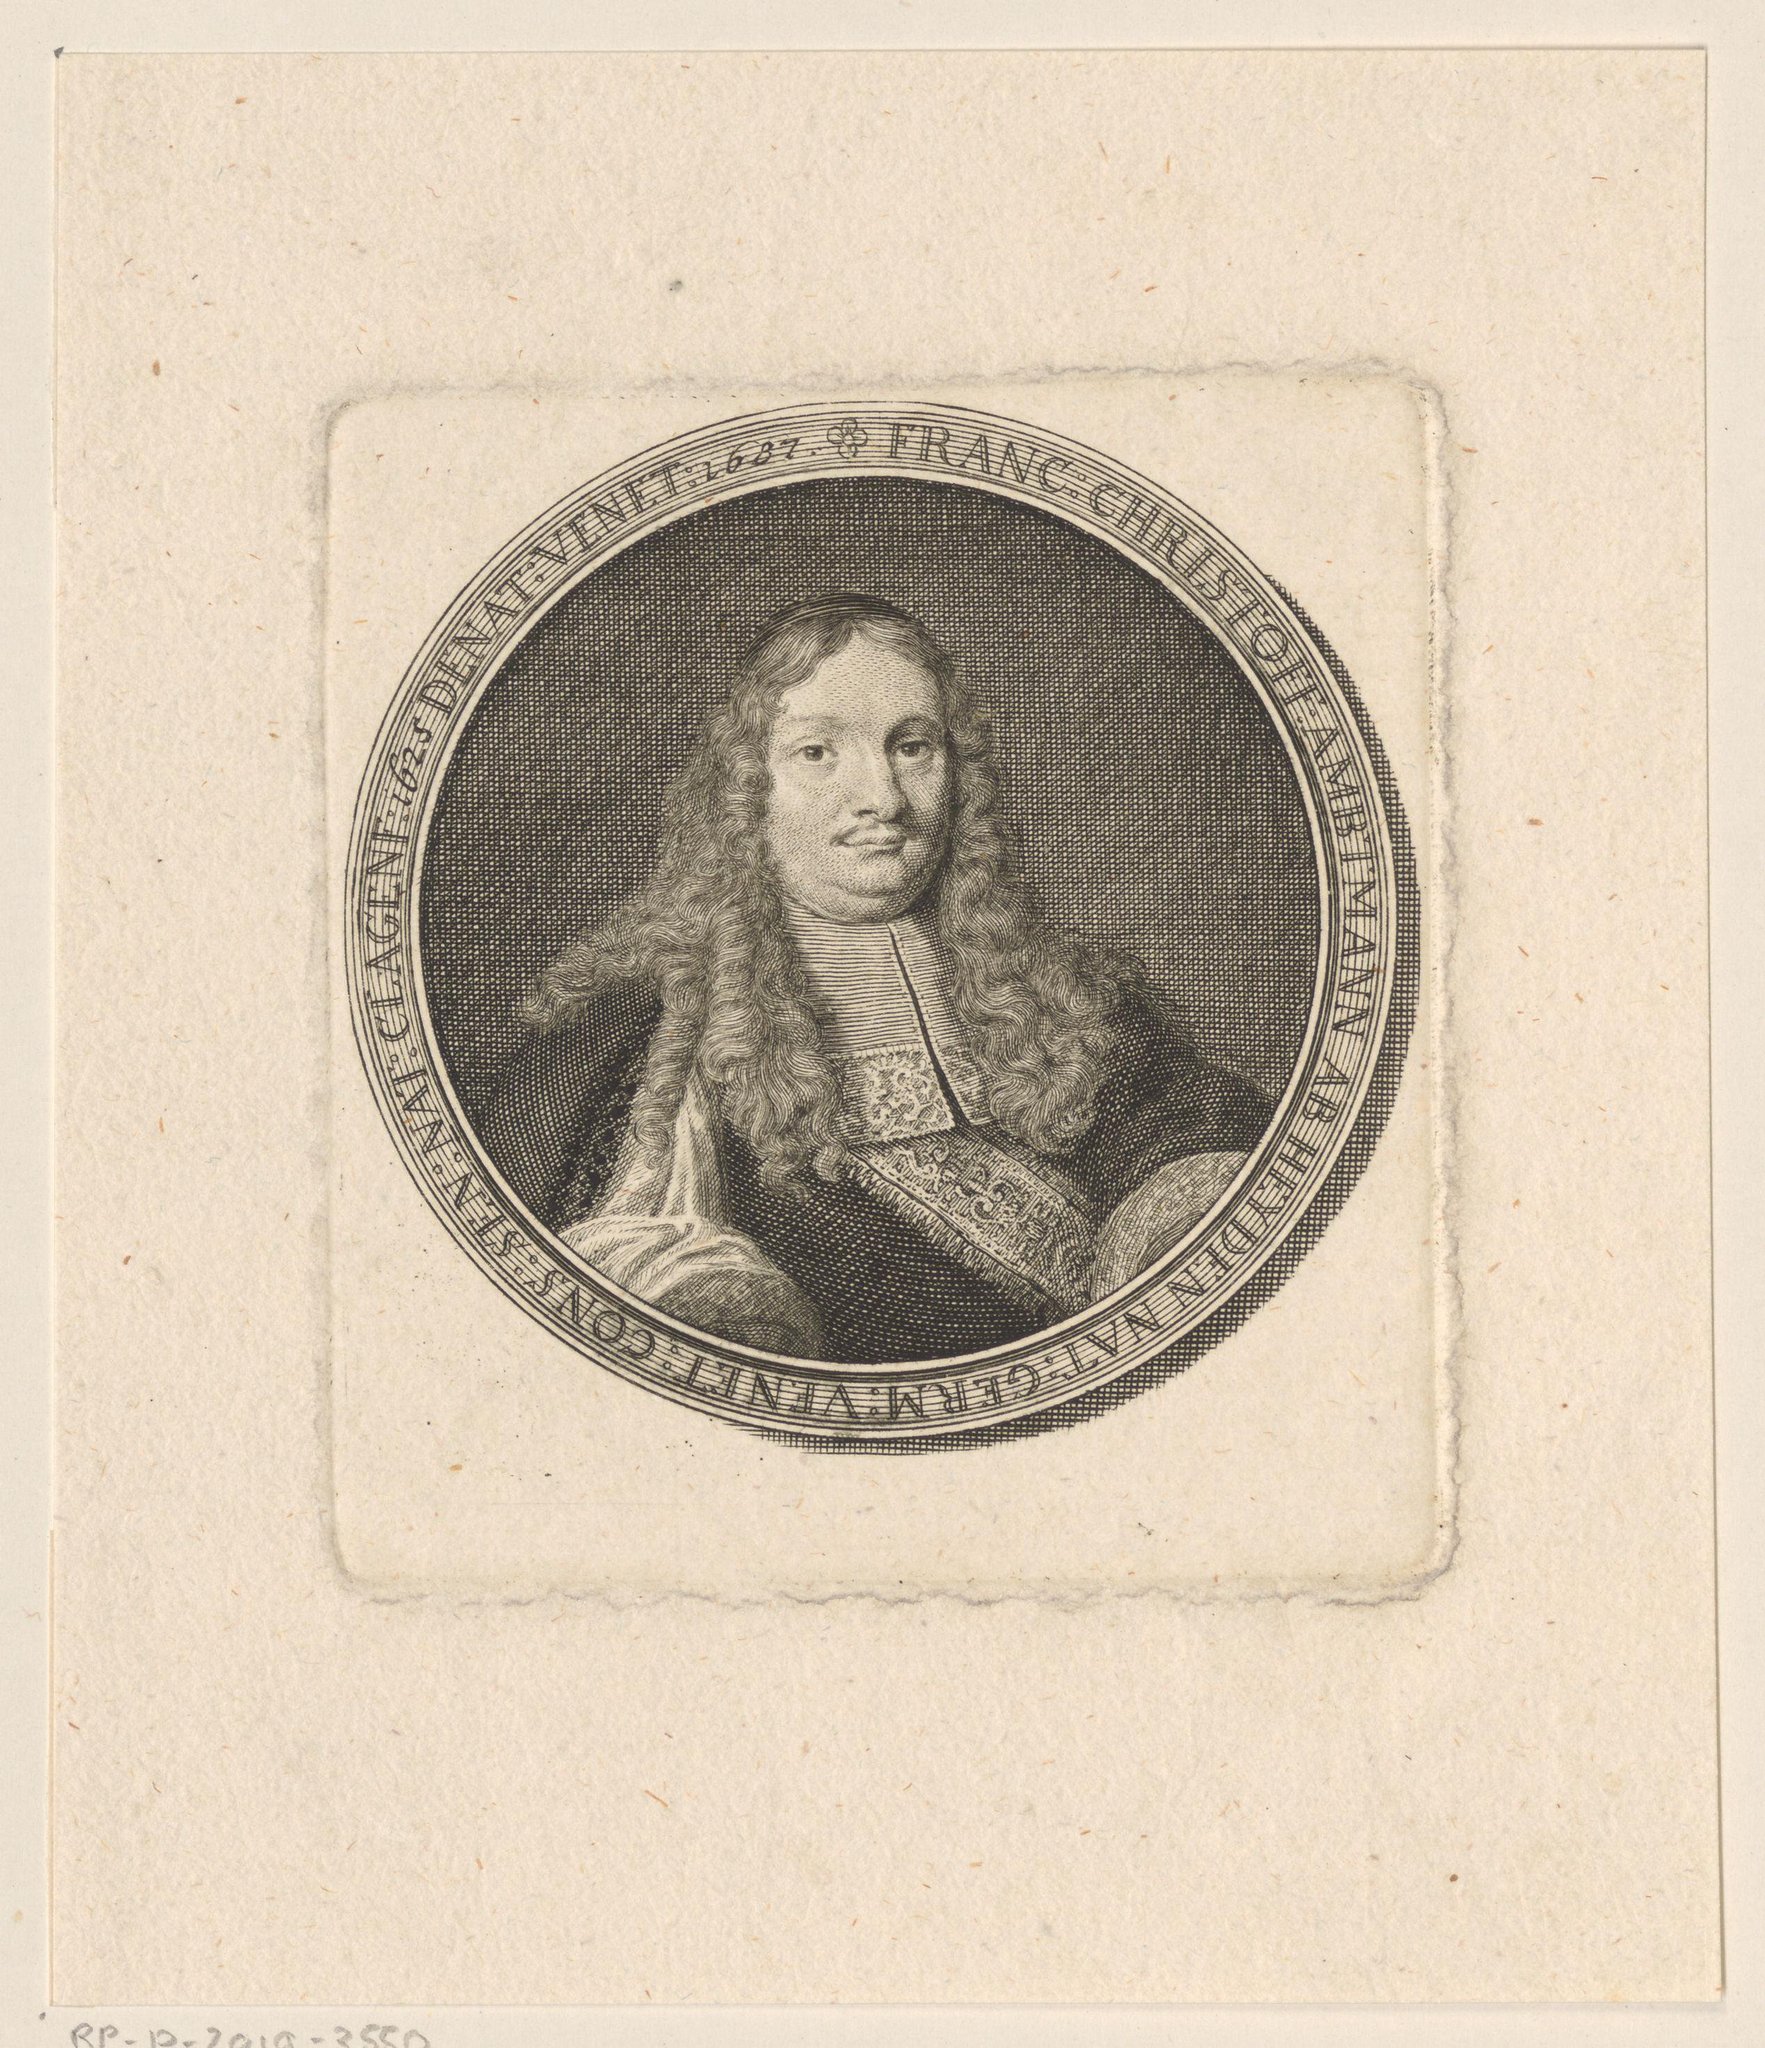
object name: print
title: Portret van Franz Christoph Ambtmann von Heyden I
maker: Anonymous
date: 1687-1750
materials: paper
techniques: engraving, etching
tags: venice, historical persons